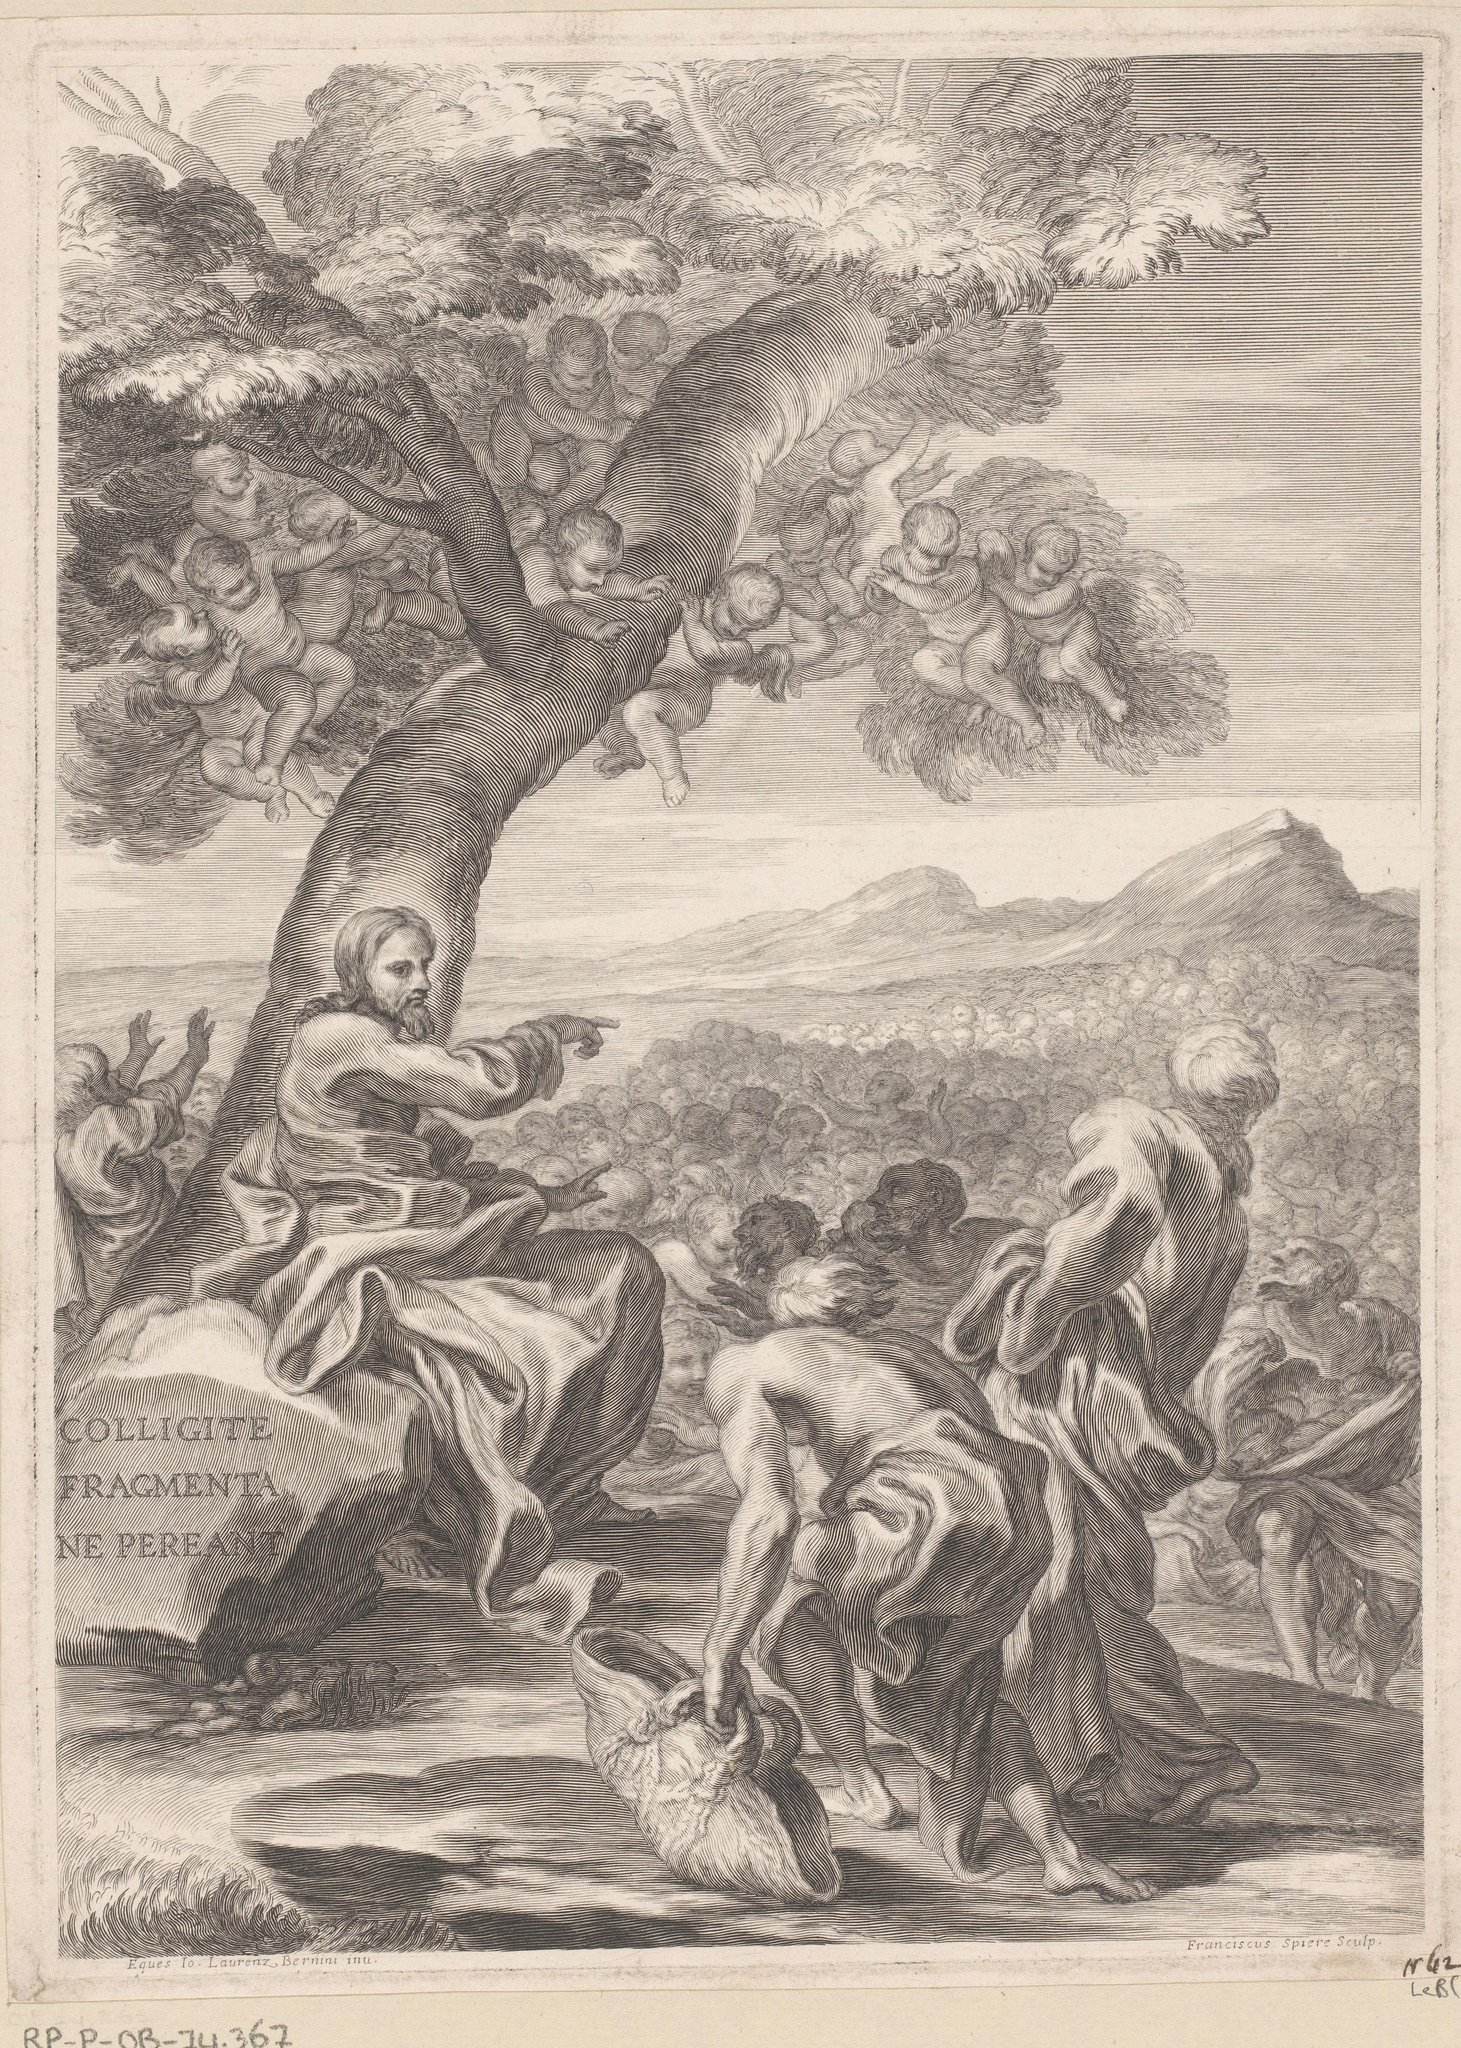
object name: print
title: Wonderbaarlijke vermenigvuldiging van broden en vissen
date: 1649-1681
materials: paper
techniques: engraving, etching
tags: multiplication of loaves and fishes for a multitude of four or five thousand people (matthew 14:13-21, 15:32-39; mark 6:32-44, 8:1-10; luke 9:10-17; john 6:1-14)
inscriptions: collector's mark: Lugt 240